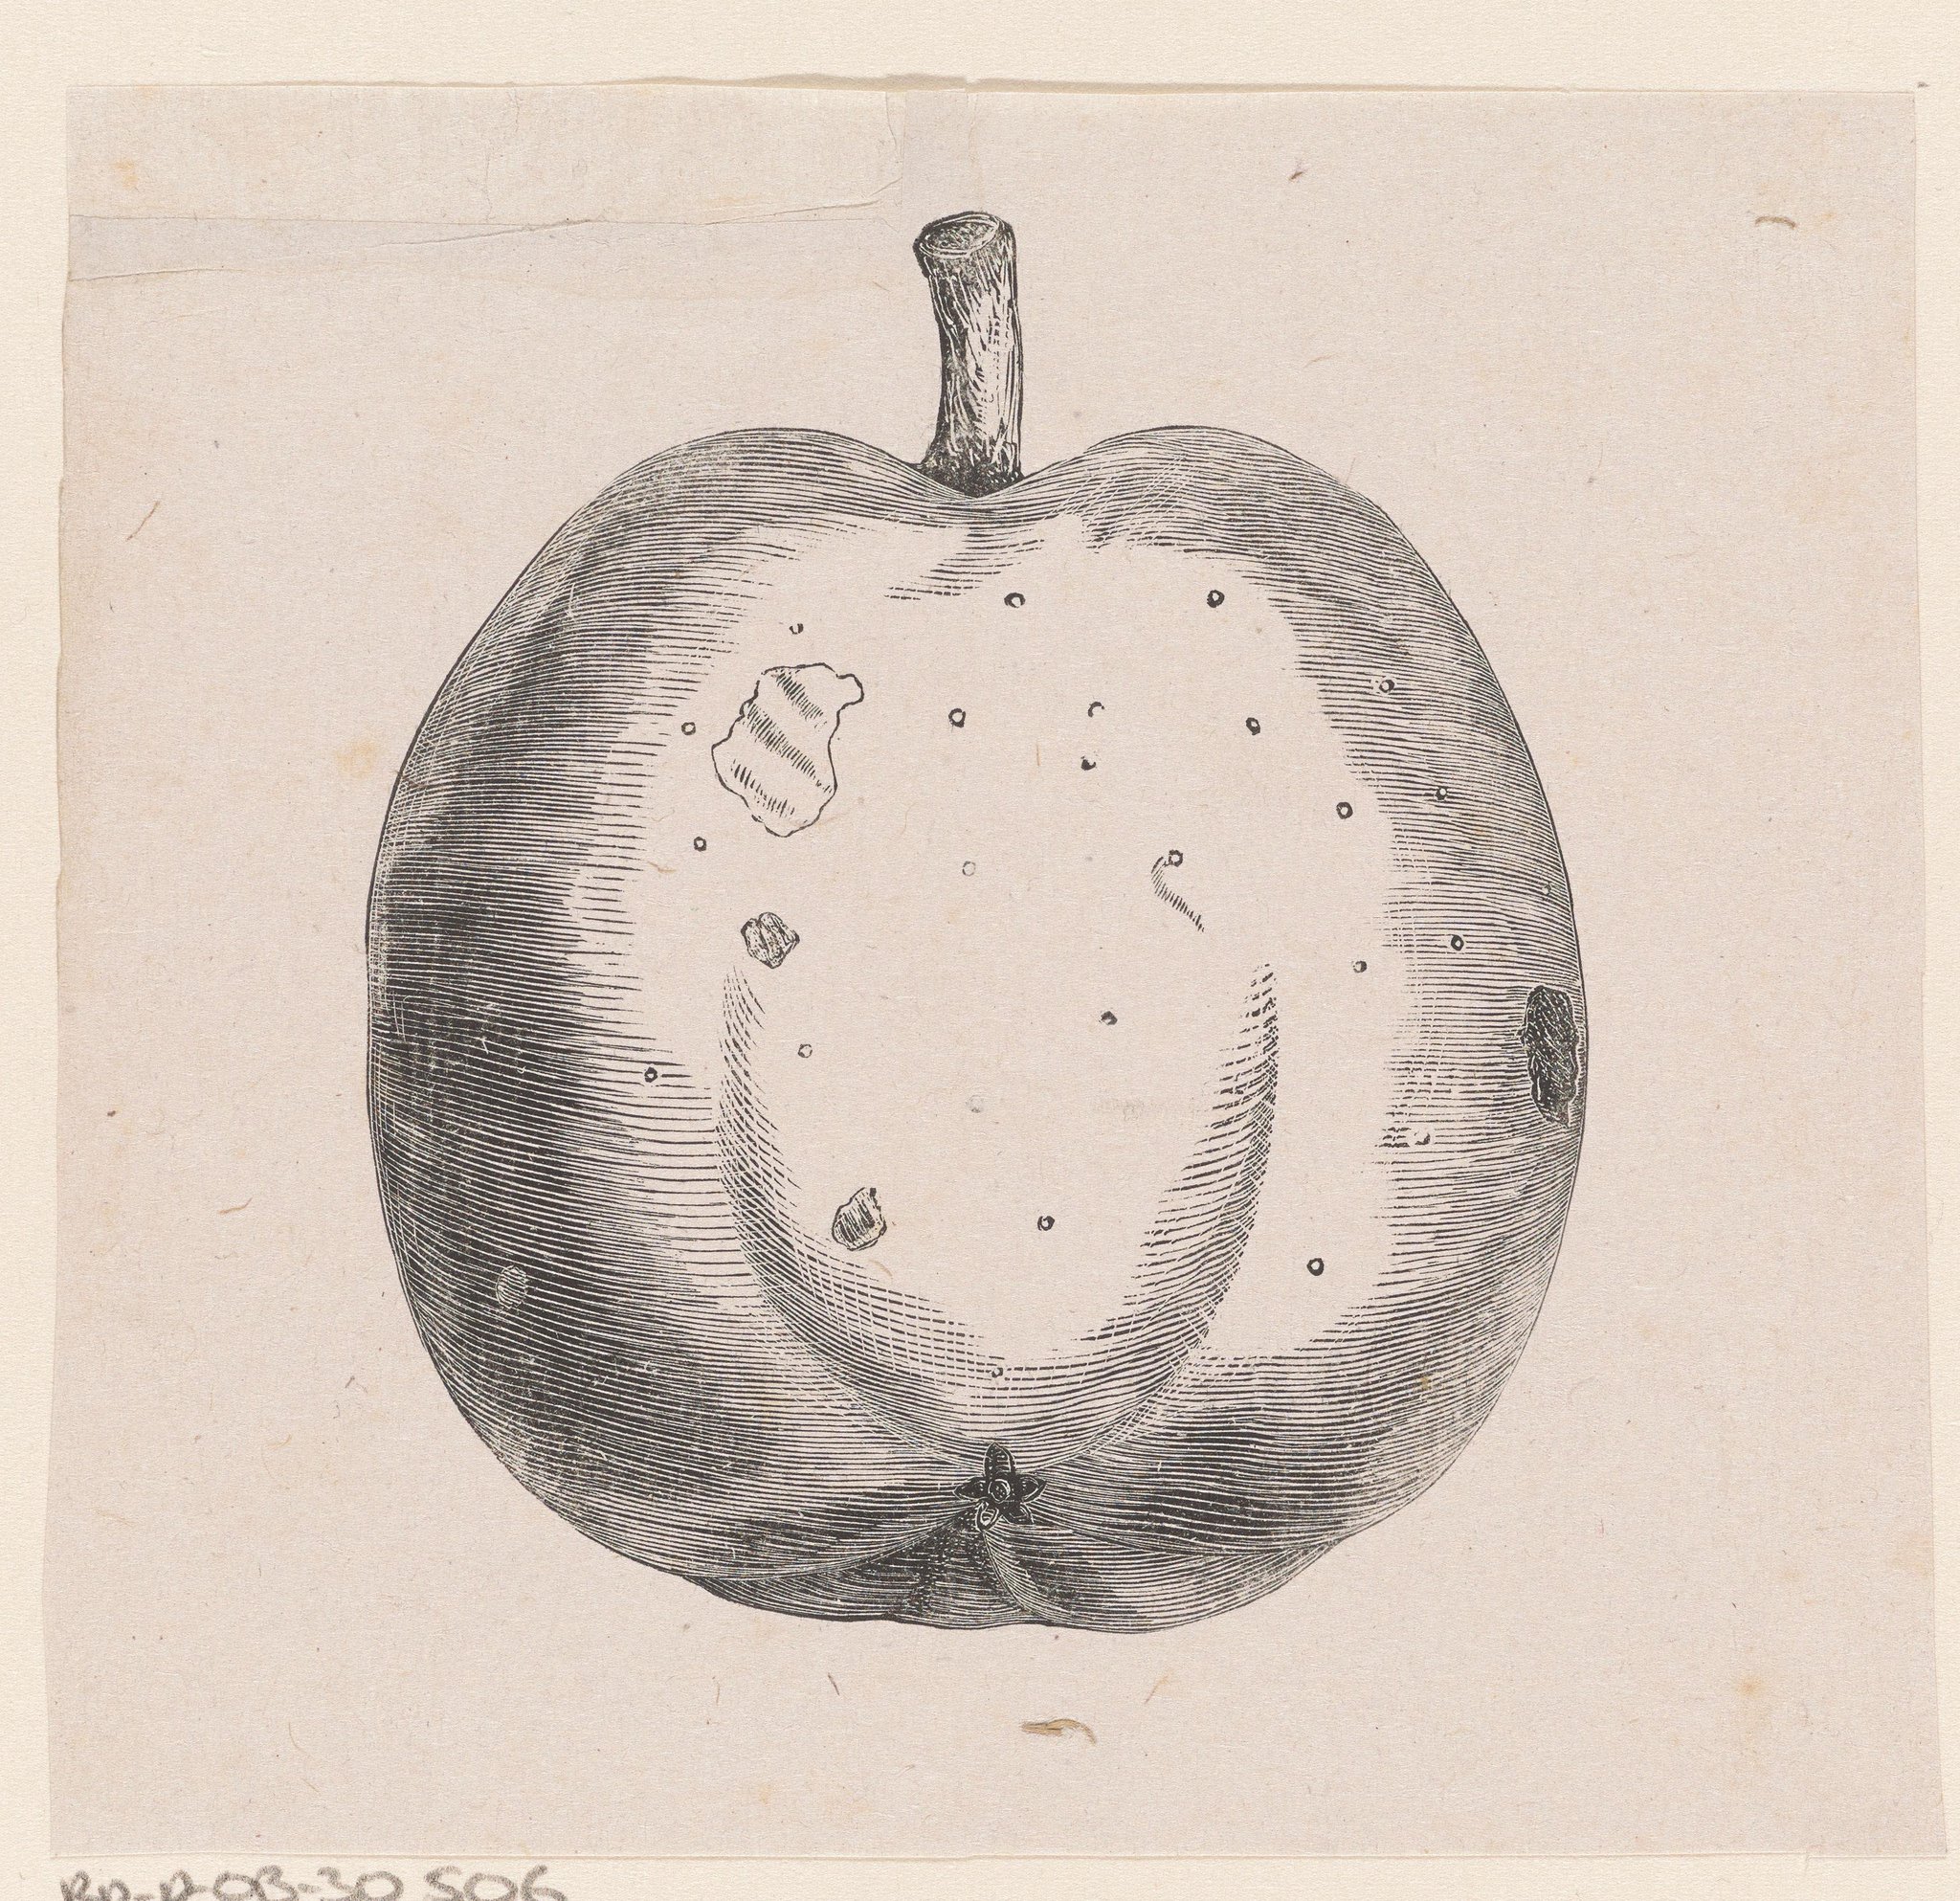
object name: print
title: Aangetaste appel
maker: isaac weissenbruch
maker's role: print maker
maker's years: 1826-1912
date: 1836-1912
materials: paper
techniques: engraving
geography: netherlands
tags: fruits: apple